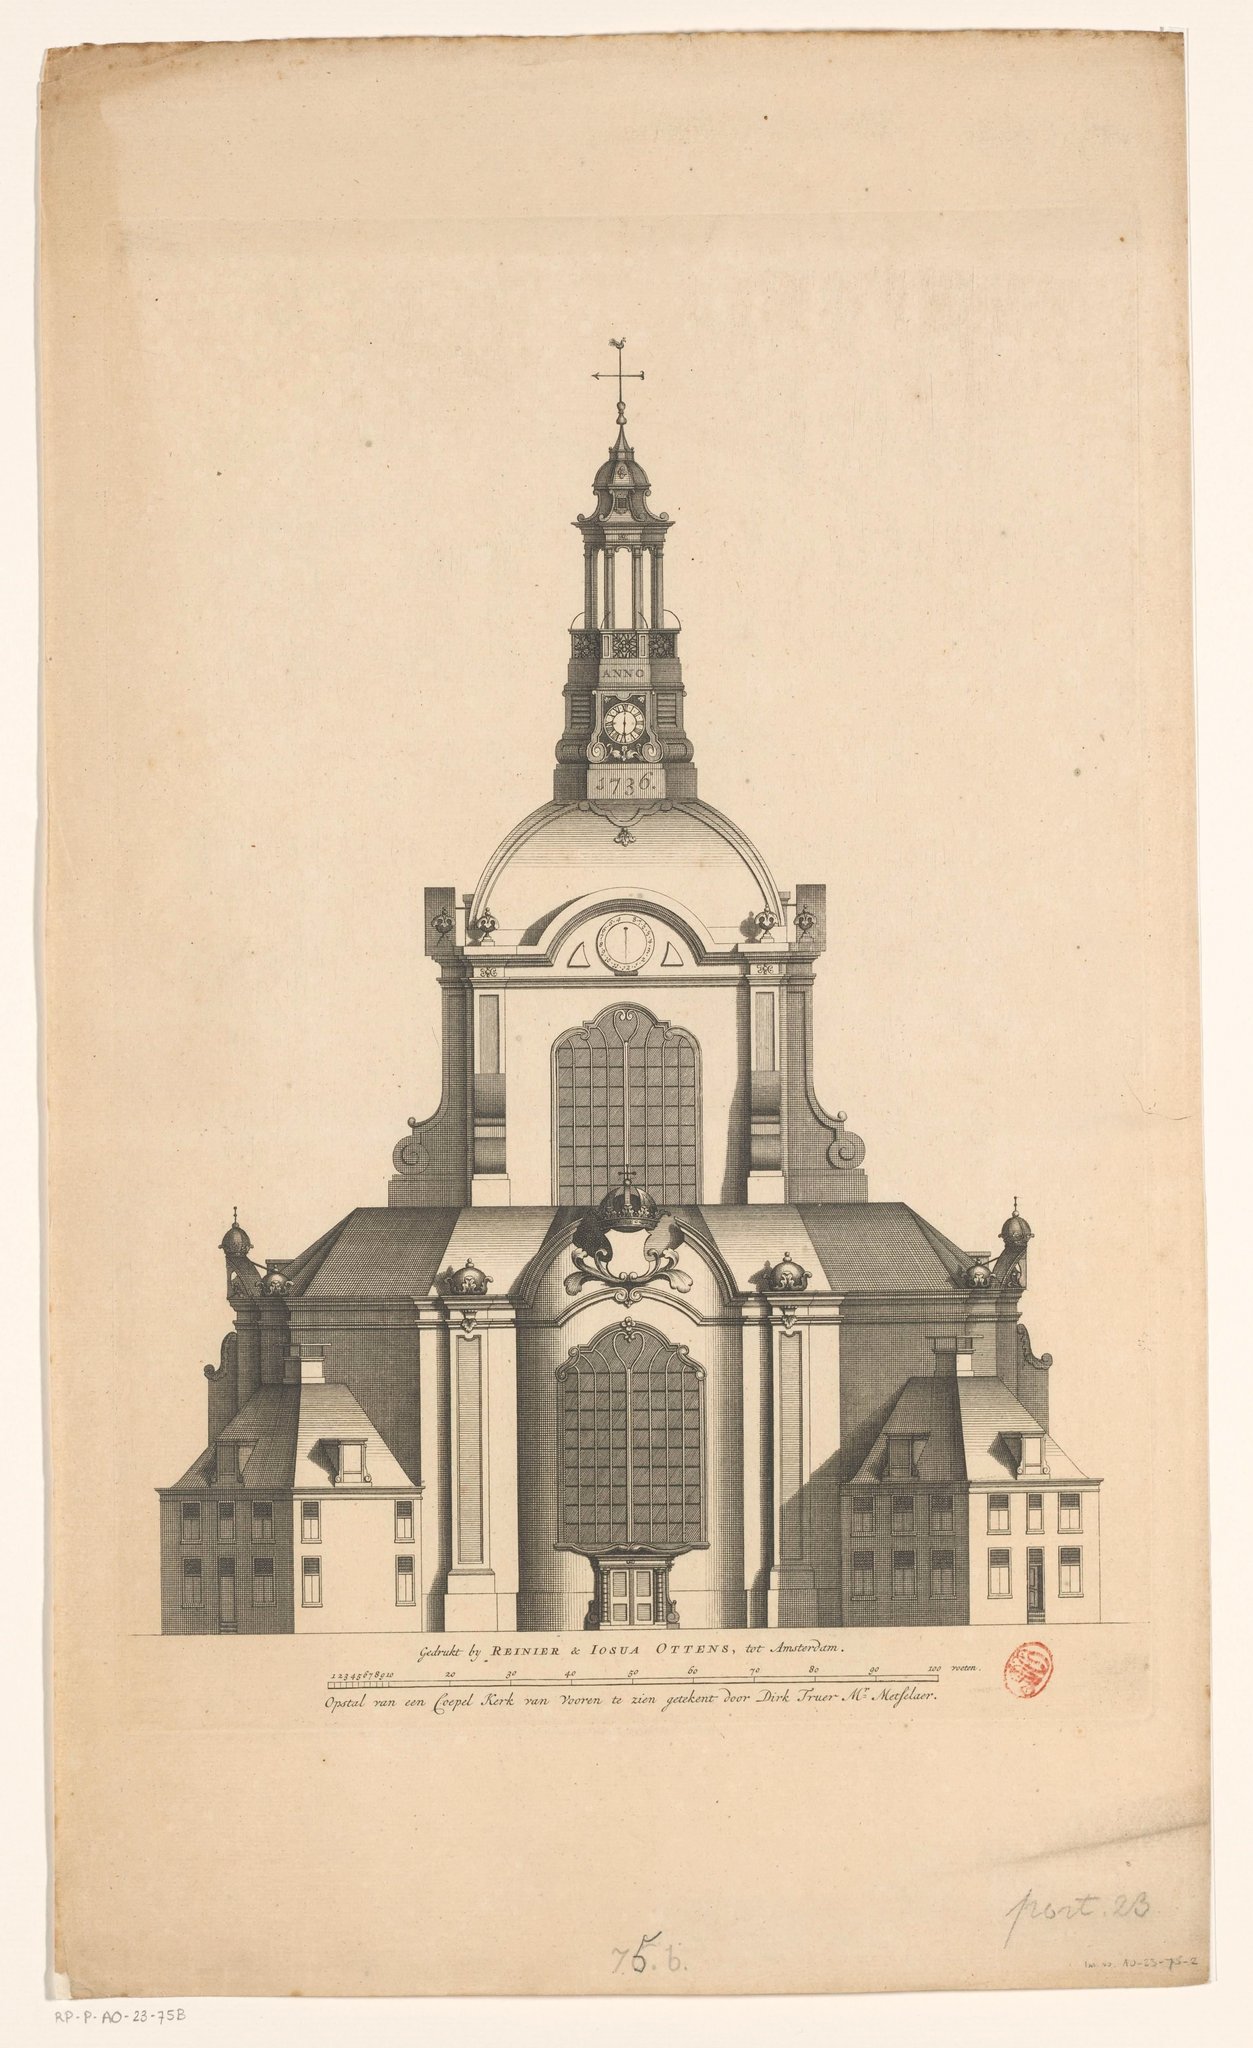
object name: print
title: Vooraanzicht van een koepelkerk op de Botermarkt te Amsterdam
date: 1736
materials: paper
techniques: engraving, etching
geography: amsterdam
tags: church (exterior), exterior ~ architectural design or model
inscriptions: collector's mark: Lugt 195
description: Vooraanzicht van een koepelkerk voor op de Botermarkt, het huidige Rembrandtplein, te Amsterdam. Onder in het midden een schaalstok: 100 voeten. Niet uitgevoerd architectuurontwerp.